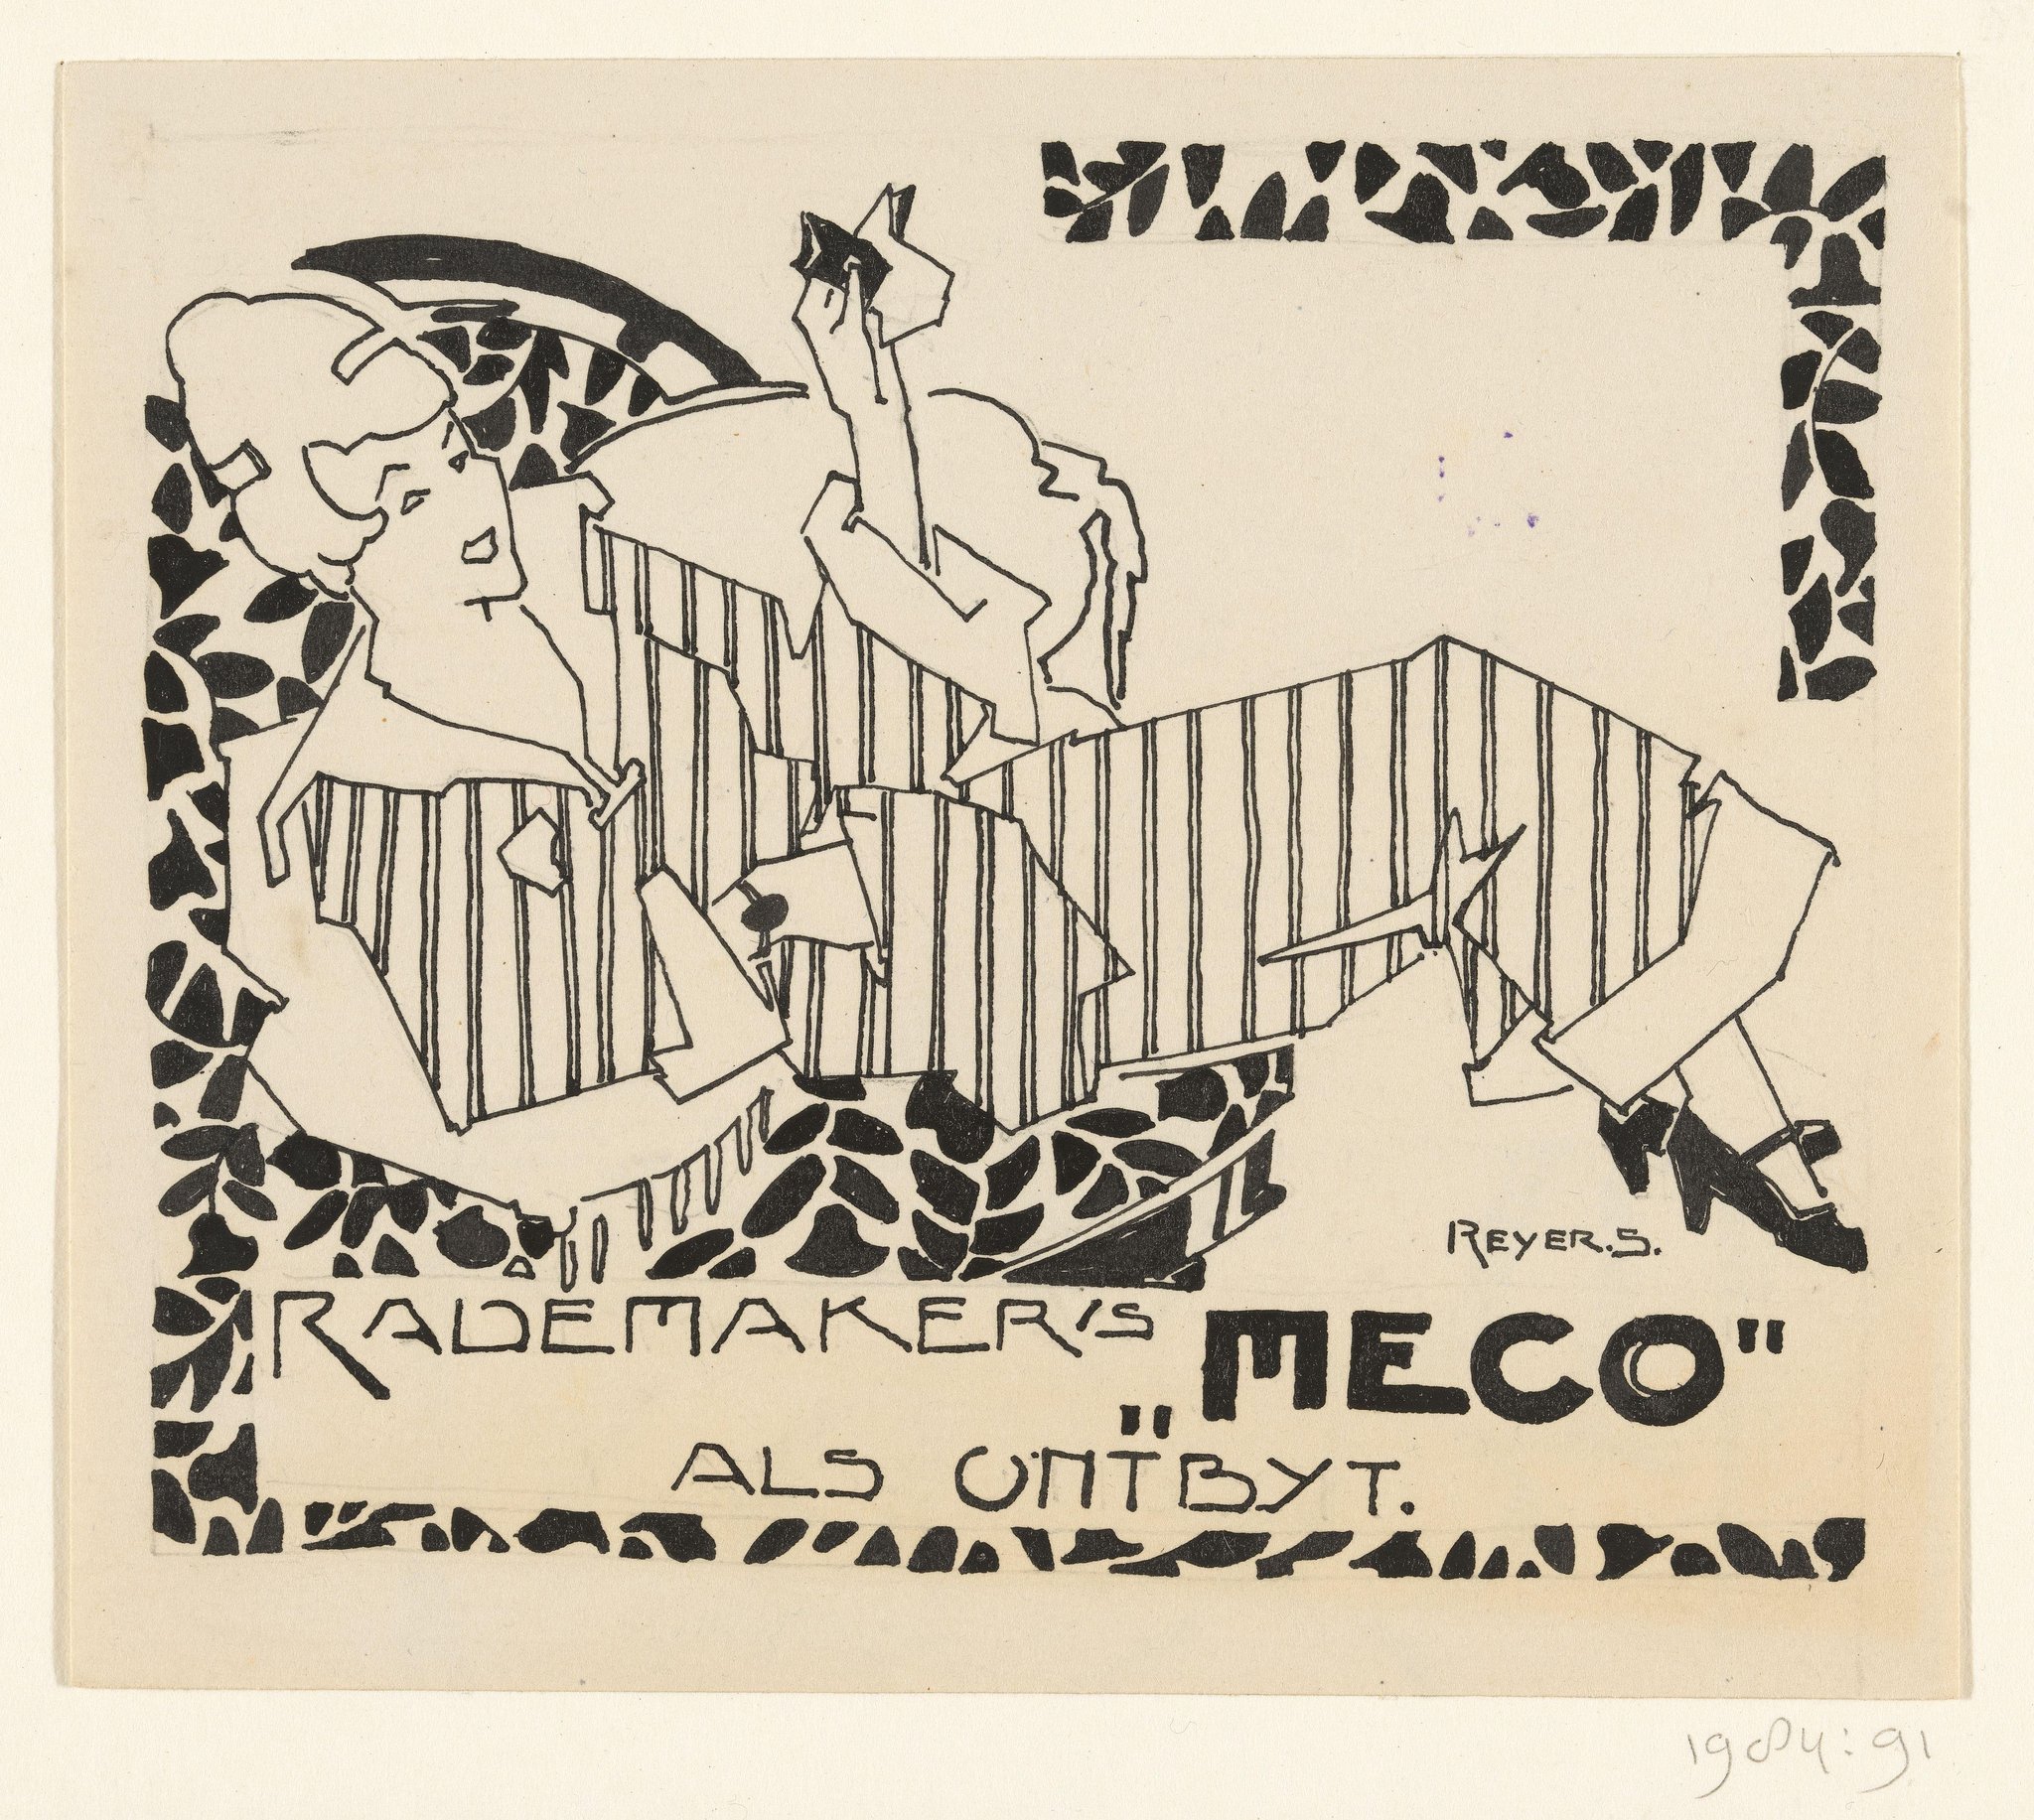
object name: drawing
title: Rademaker's "Meco" als ontbijt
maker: reijer stolk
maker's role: draughtsman, print maker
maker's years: 1896-1945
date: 1906-1945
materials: ink, paper, pencil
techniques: brush, pen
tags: (other) historical names, advertisement, notice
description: Deze tekening is mogelijk een ontwerp voor een advertentie.